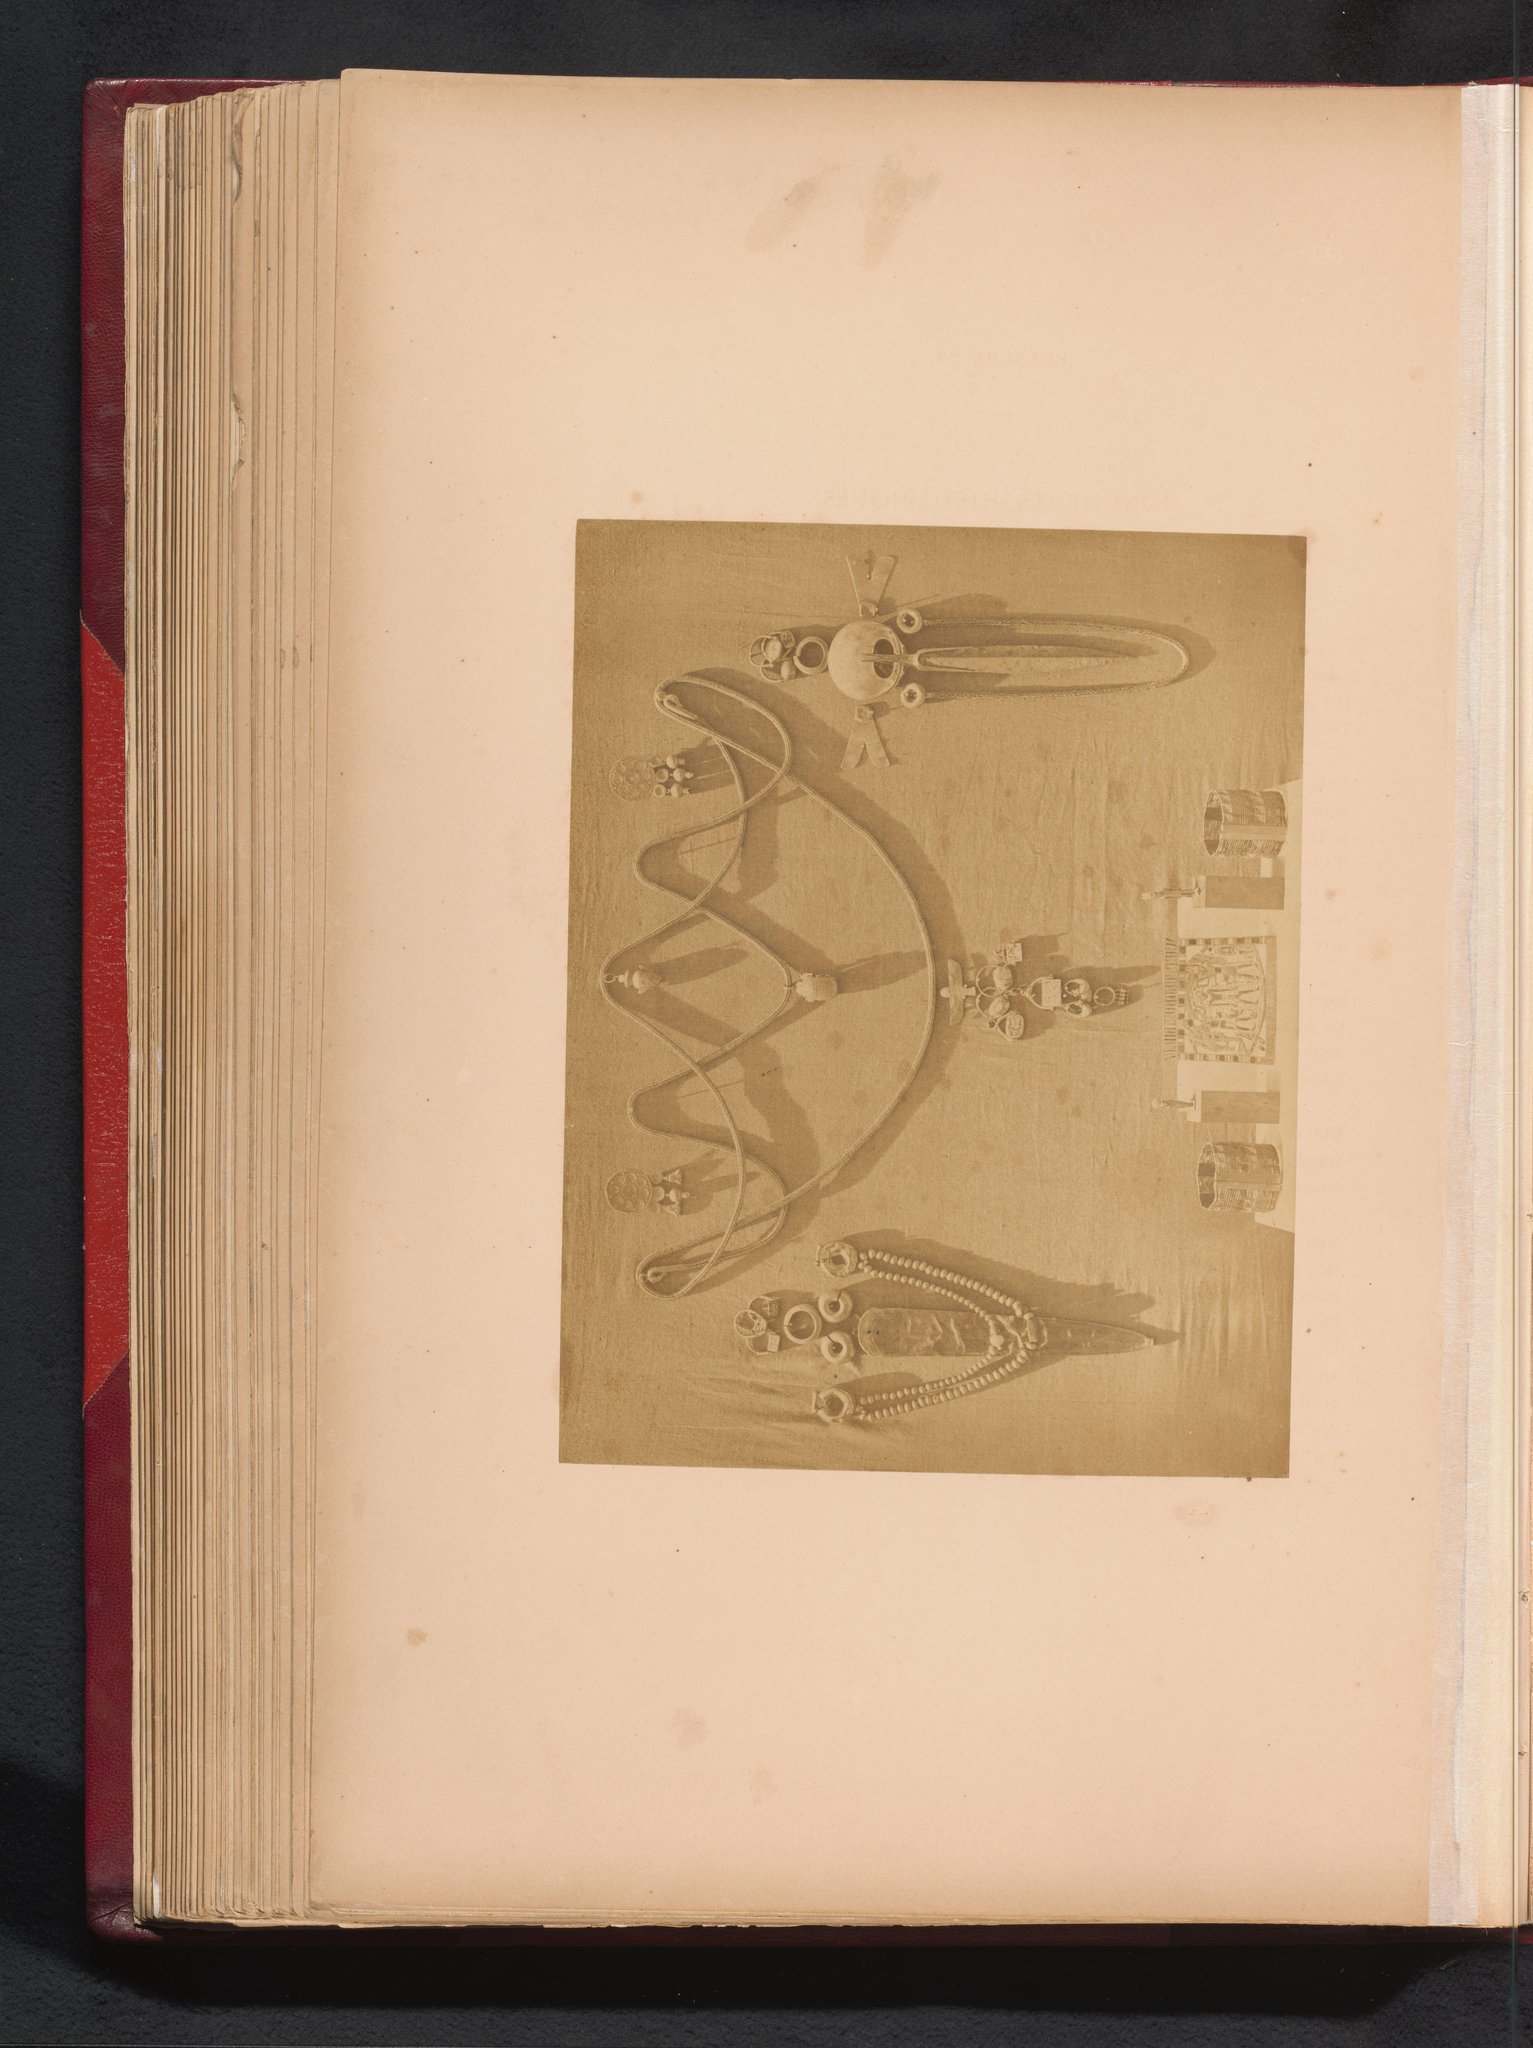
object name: page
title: Sieraden uit het graf van Ahhotep I, opgesteld in het Boulaq Museum in Caïro, Egypte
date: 1866-1871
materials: photographic support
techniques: albumen print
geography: cairo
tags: ornaments, jewels, permanent exhibition, museum